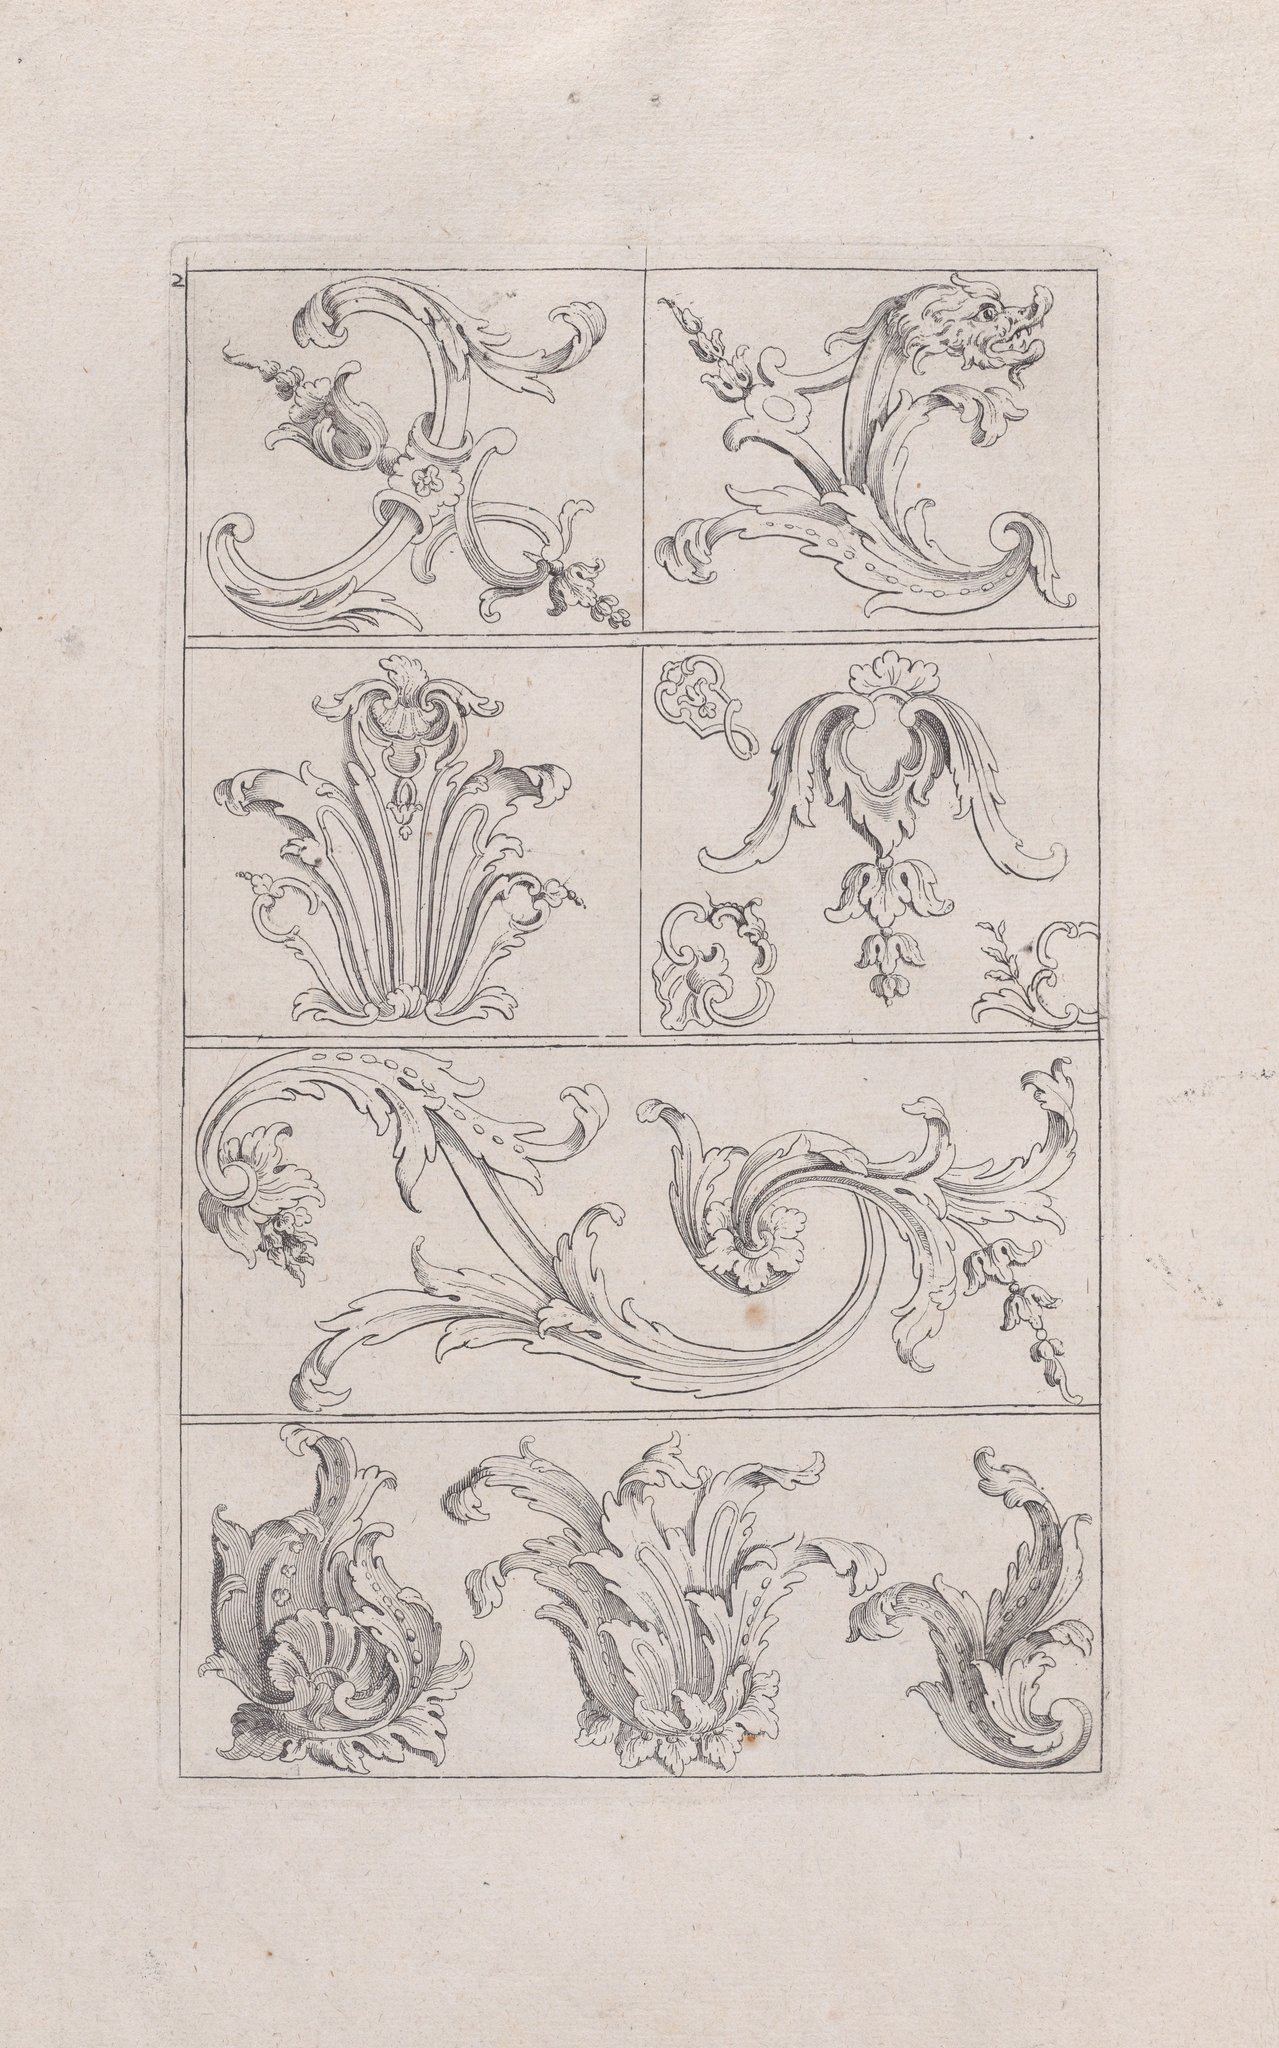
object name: print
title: Plate 2, from "Livre Nouveau de Prinsipes D'Ornemens, tres facil. Pour apprendre a Dessigner"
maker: nicolas guérard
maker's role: artist and publisher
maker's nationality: french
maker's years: 1648-1719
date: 1715-1725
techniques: engraving